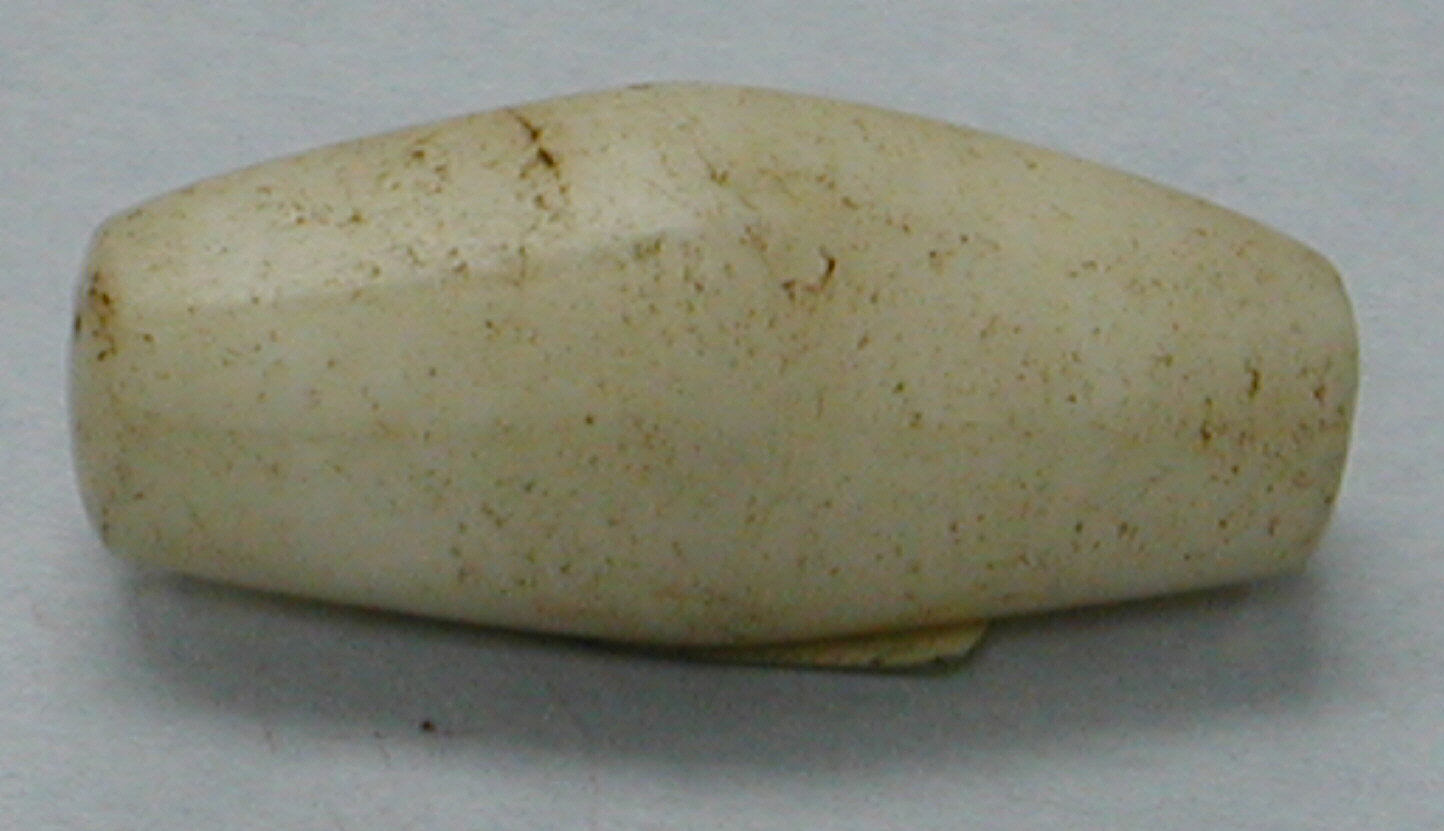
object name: ritual stone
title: Stone Pulidor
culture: mexican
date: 1501-1600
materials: stone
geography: mexico